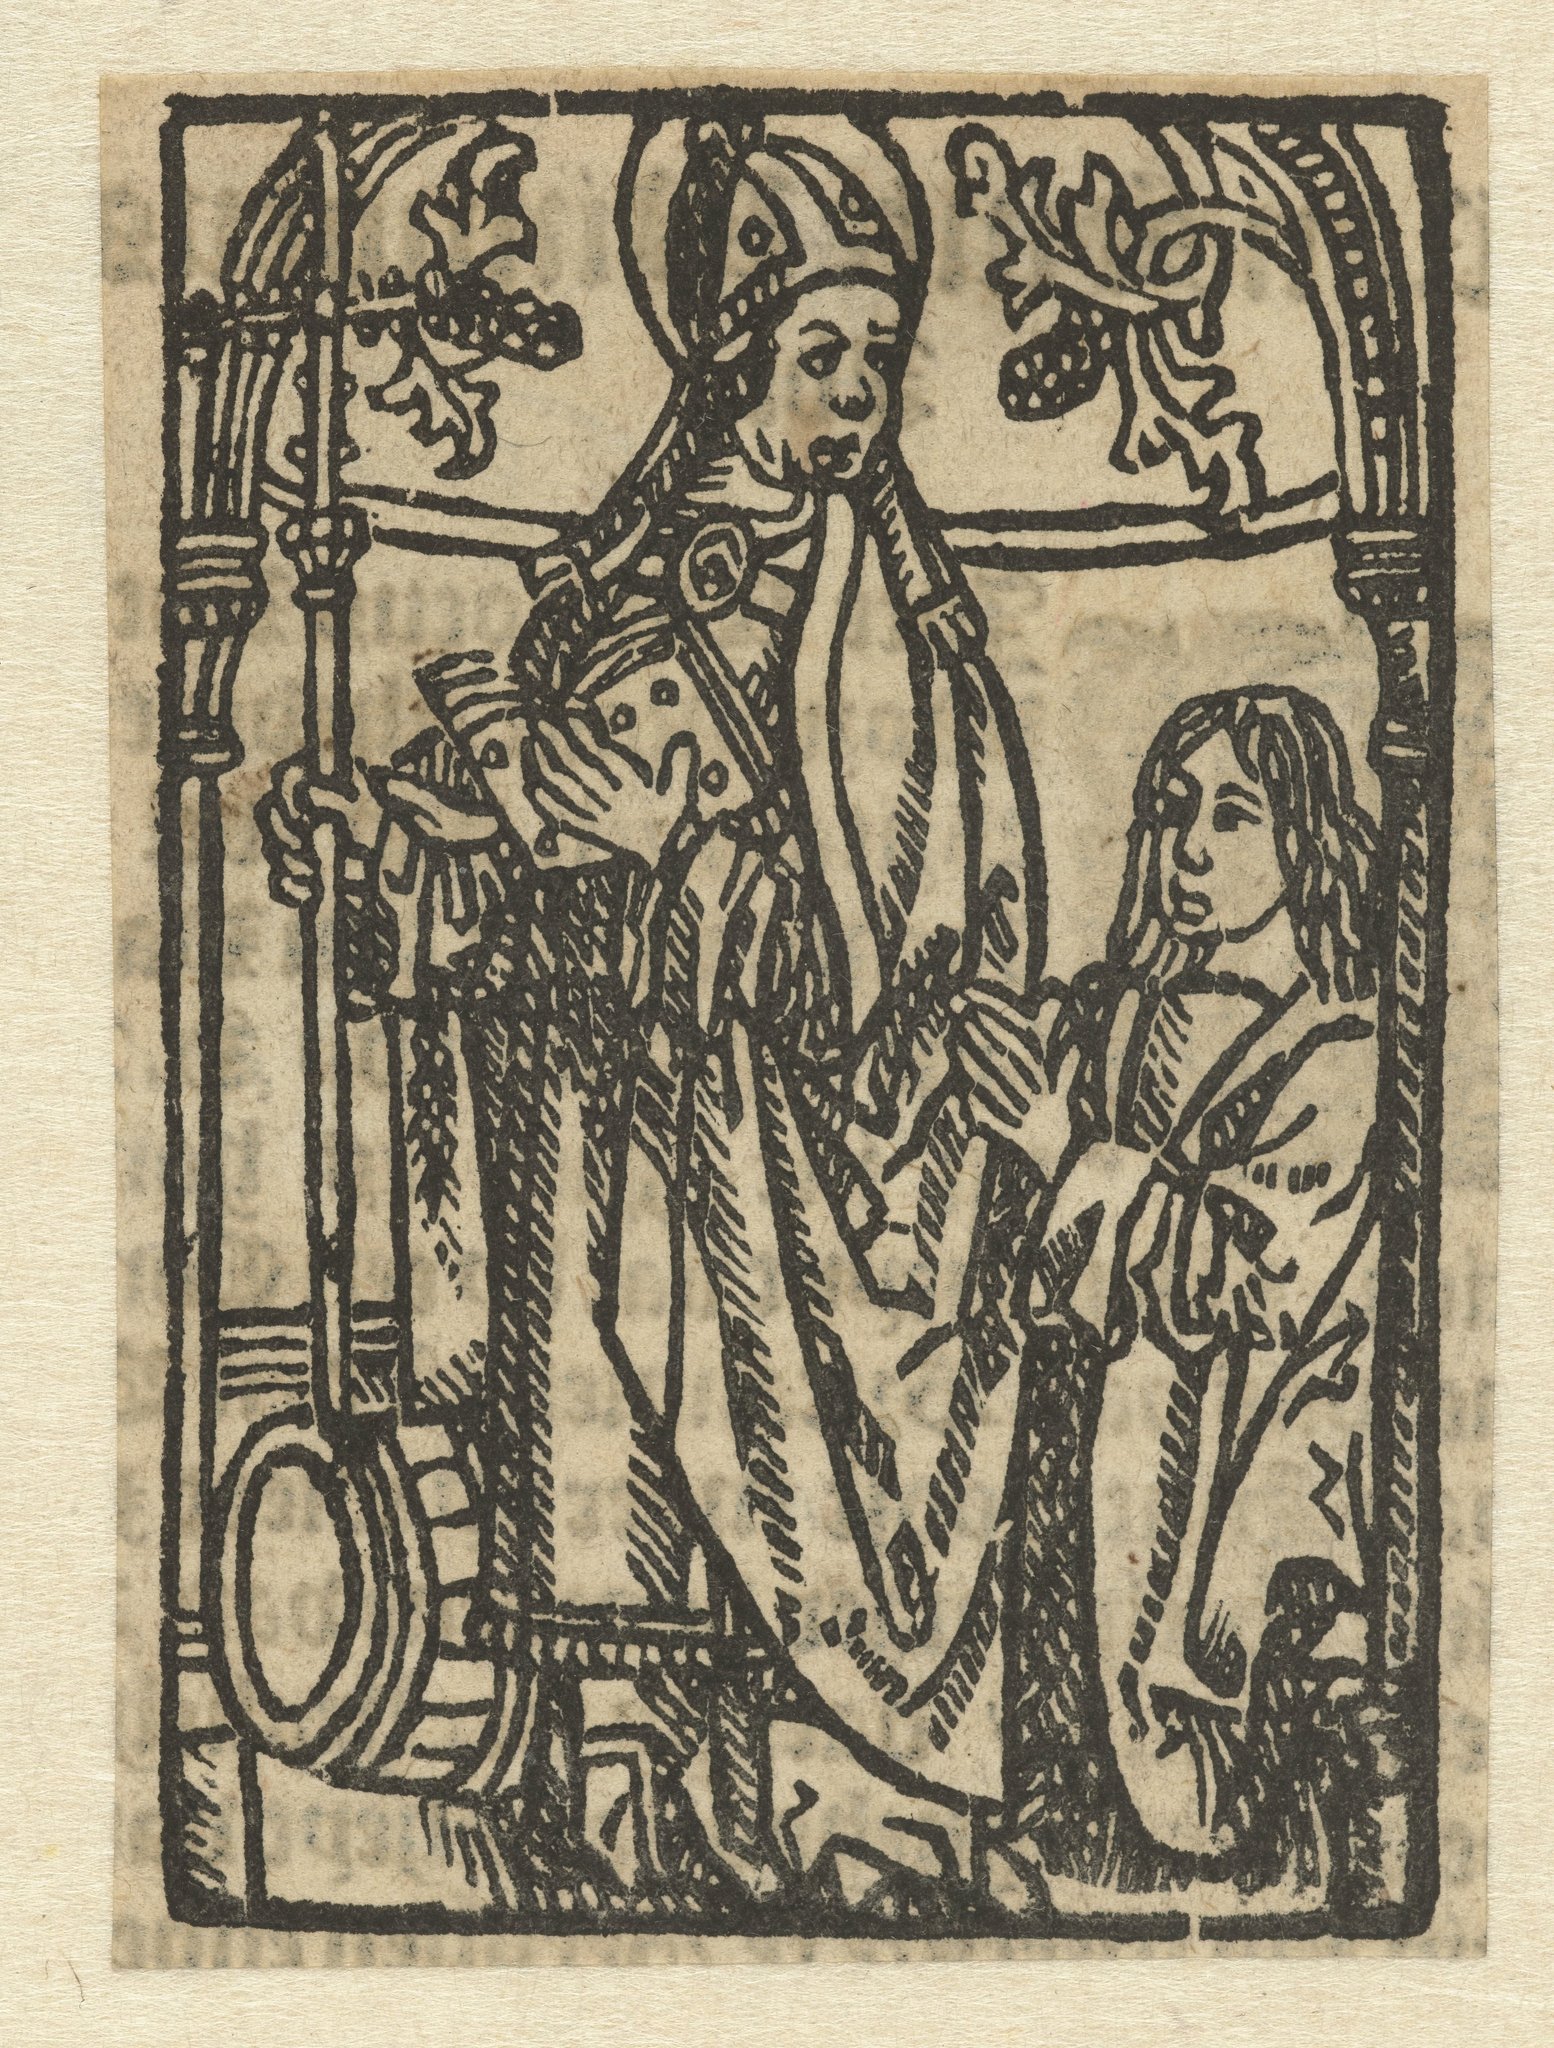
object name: print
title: Heilige Bisschop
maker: Anonymous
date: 1604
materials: paper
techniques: woodcut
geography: low countries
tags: archbishop, bishop, etc. (roman catholic), st. willibrord multiplies wine by putting his staff in the cask, bunch of grapes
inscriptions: collector's mark: Lugt 2228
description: De heilige bisschop Willibrordus (?) steunt met zijn staf op een ton. Boven zijn hoofd hangen twee trossen druiven. Naast hem een knielende stichter.